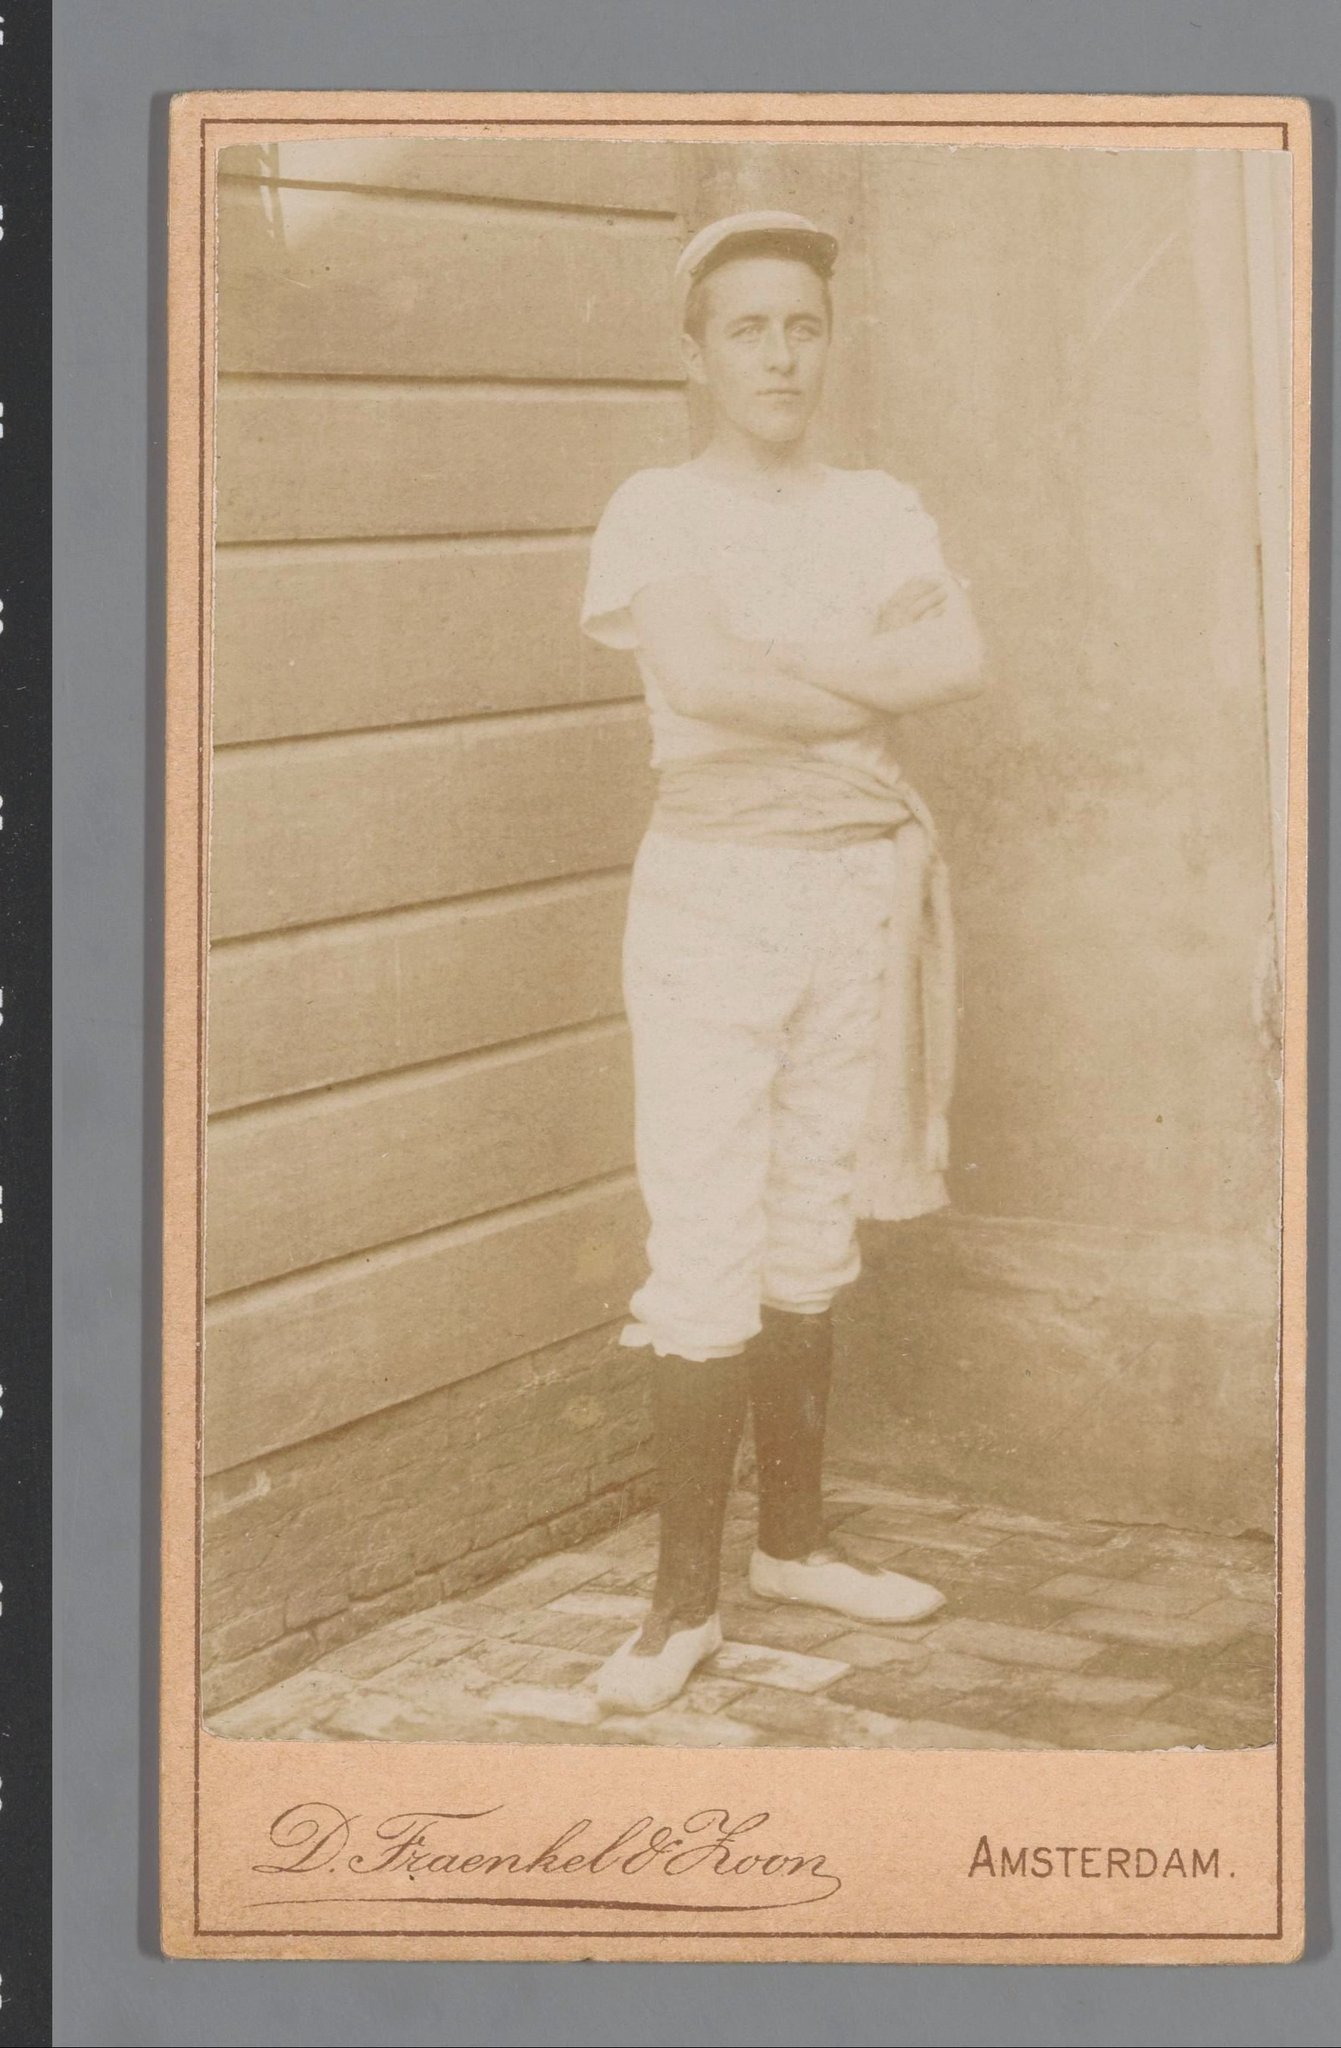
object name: photograph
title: Portret van een onbekende man (vermoedelijk) in sportkleding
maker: david fraenkel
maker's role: fotograaf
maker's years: 1845-1930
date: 1895-1915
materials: cardboard, photographic support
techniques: gelatin silver print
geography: amsterdam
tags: adult man, clothes, costume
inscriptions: inscription: ‘D. Fraenkel & Zoon photographen Amsterdam 43. Commelinstraat 43.’